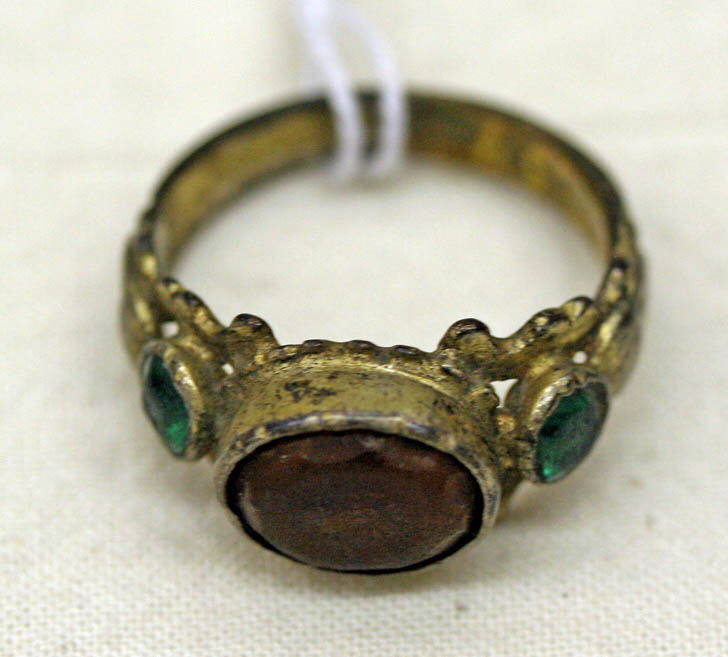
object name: ring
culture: european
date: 1701-1800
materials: metal